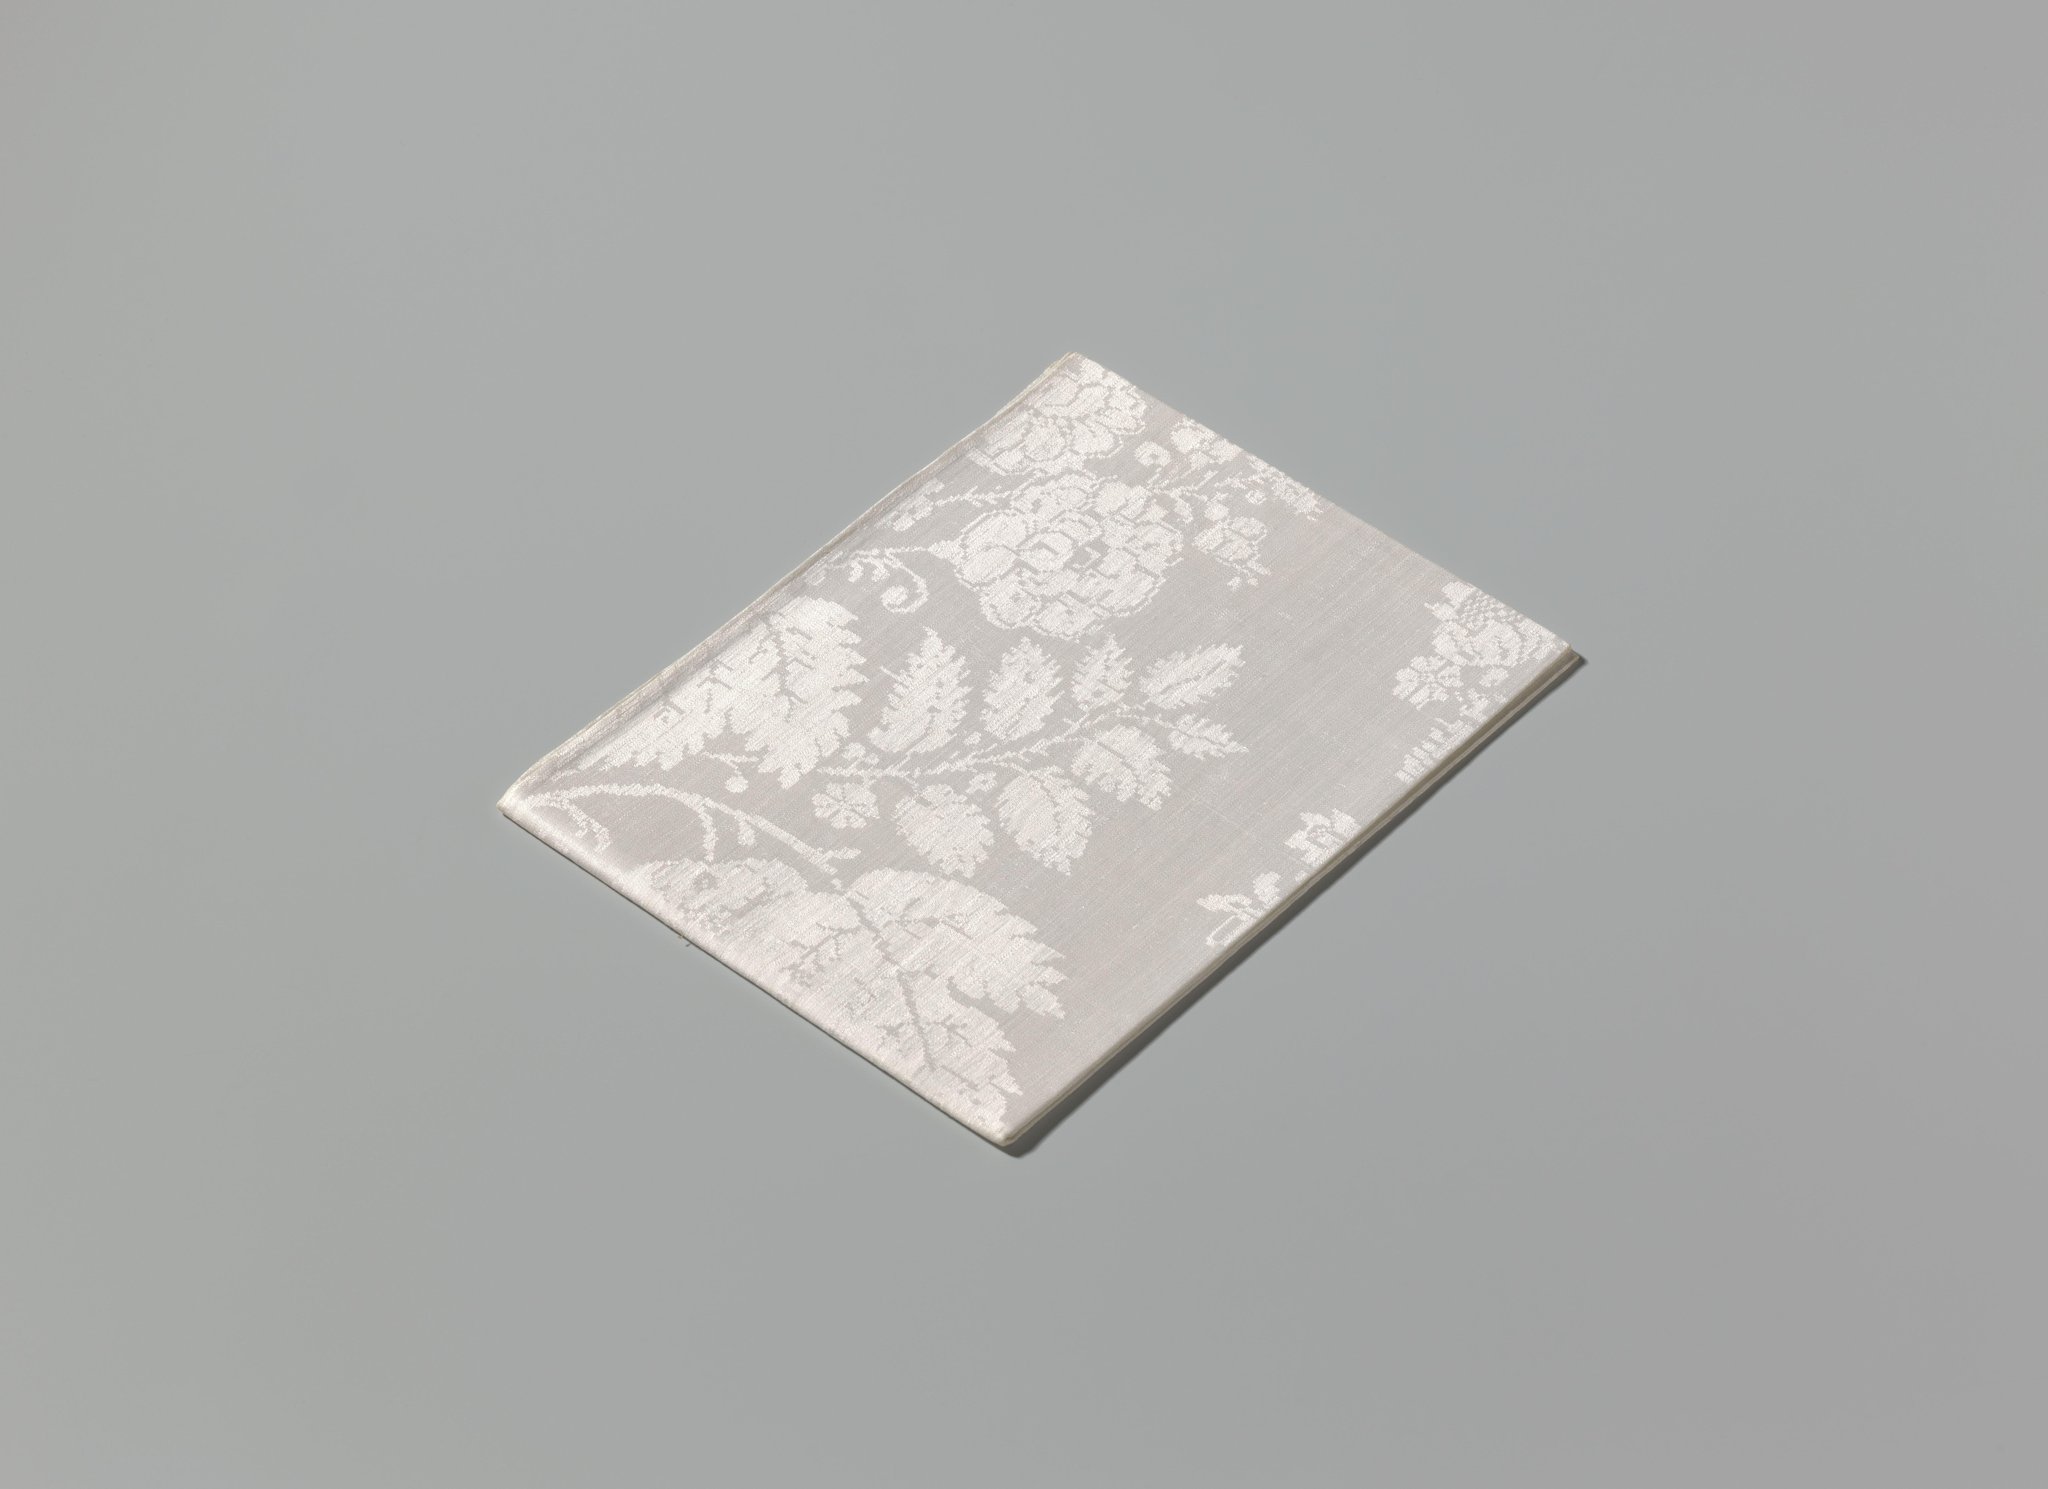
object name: napkin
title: Servet van linnendamast met een kantpatroon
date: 1725-1730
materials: linen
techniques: damask, weave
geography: northern netherlands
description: Wit linnendamasten servet met z.g. kantpatroon, merk kroon IAVG 16.